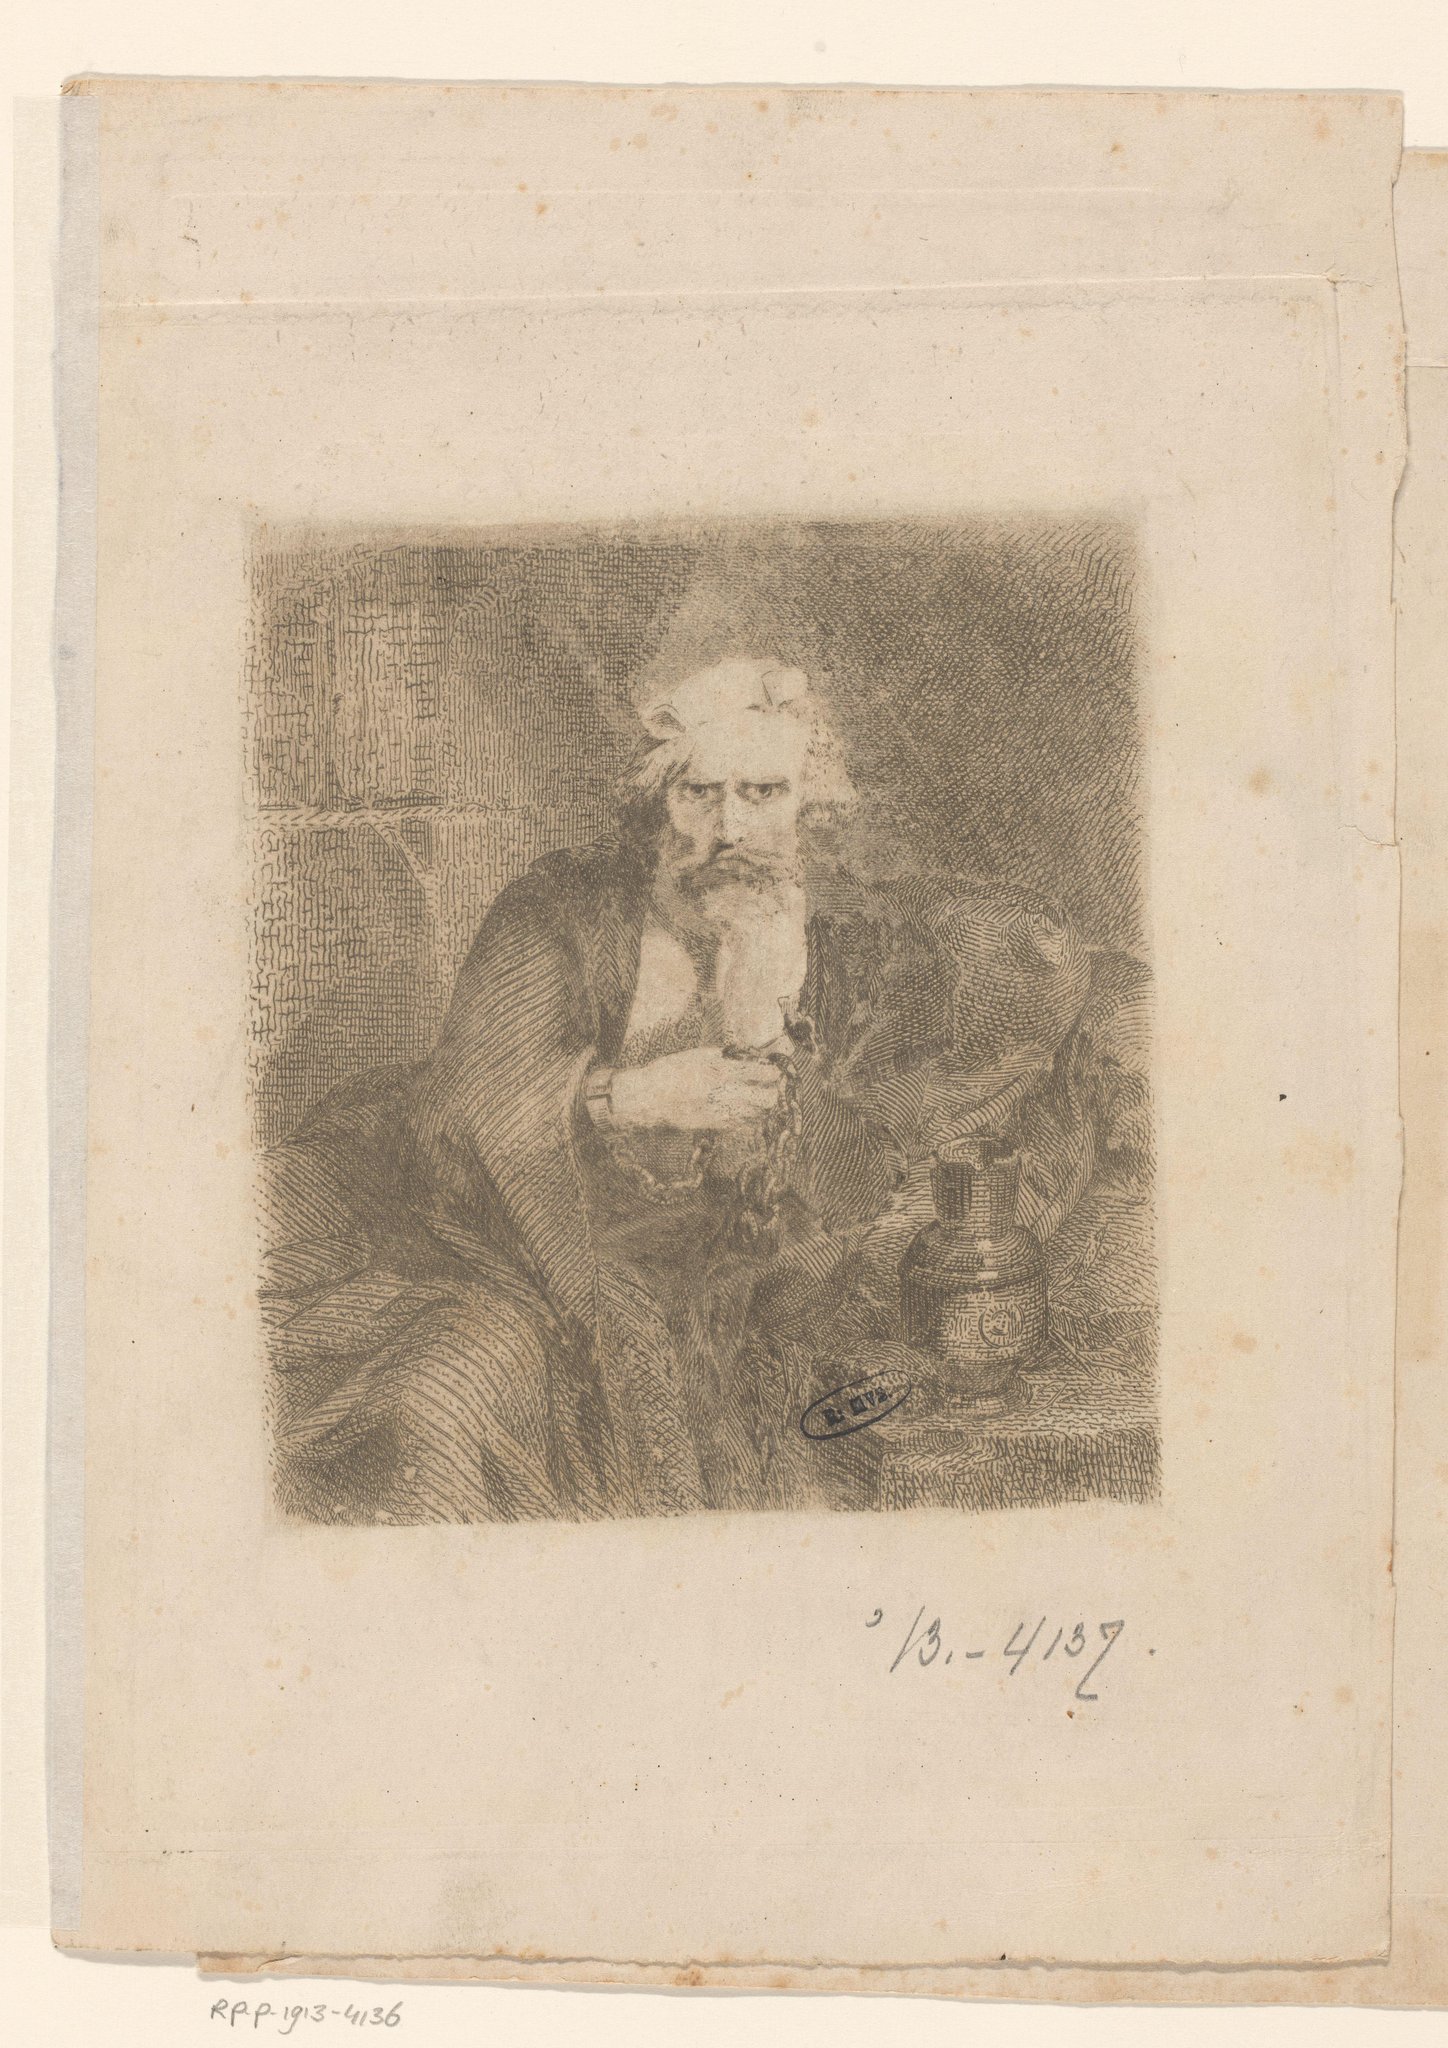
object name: print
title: Man met ketens om zijn handen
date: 1800-1874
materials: paper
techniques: etching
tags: adult man, prisoner; in fetters, beard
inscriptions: collector's mark: Lugt 2228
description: Prent hetzelfde als RP-P-1913-4136 en RP-P-1913-3994 maar in de inventaris toegeschreven aan verschillende kunstenaars.